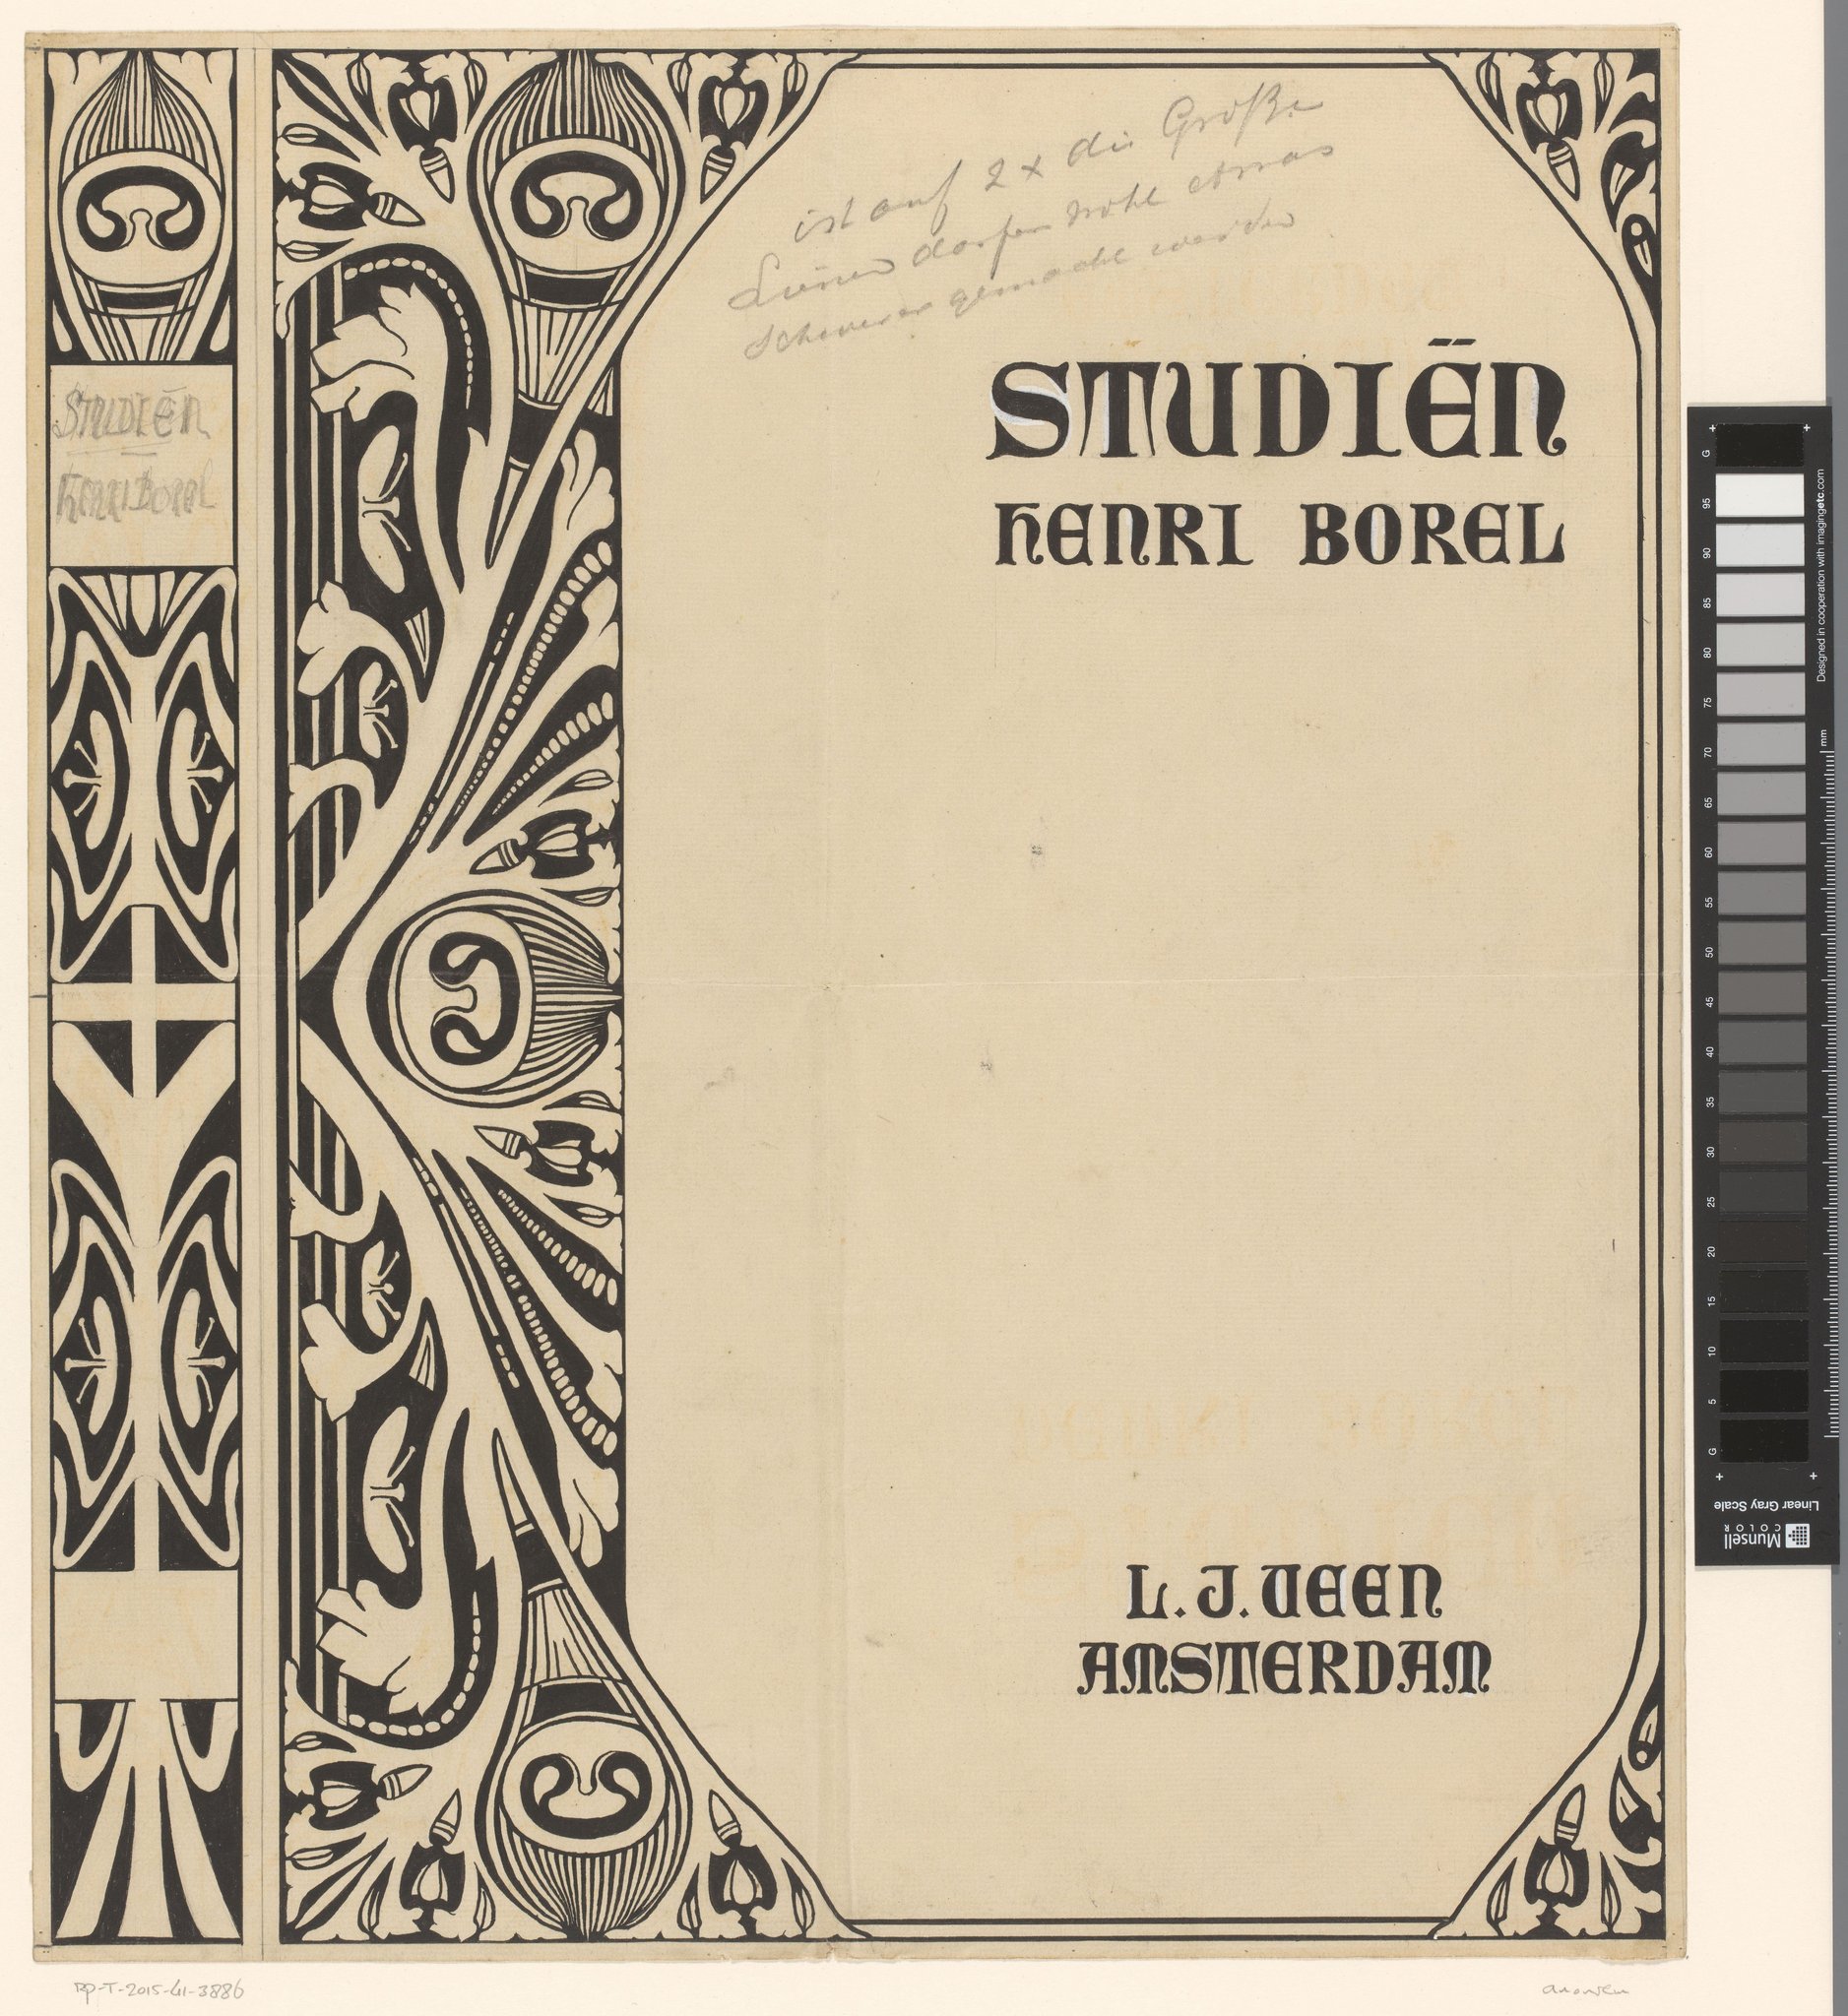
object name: study for binding design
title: Bandontwerp voor: Henri Borel, Studiën, 1898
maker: Anonymous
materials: paint, ink, paper, pencil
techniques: brush, pen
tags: ornaments ~ art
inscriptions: collector's mark: Lugt 2228a, :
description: Titel en auteursnaam in een rechthoekig kader met daaromheen en doorlopend over de boekrug ornamenten.